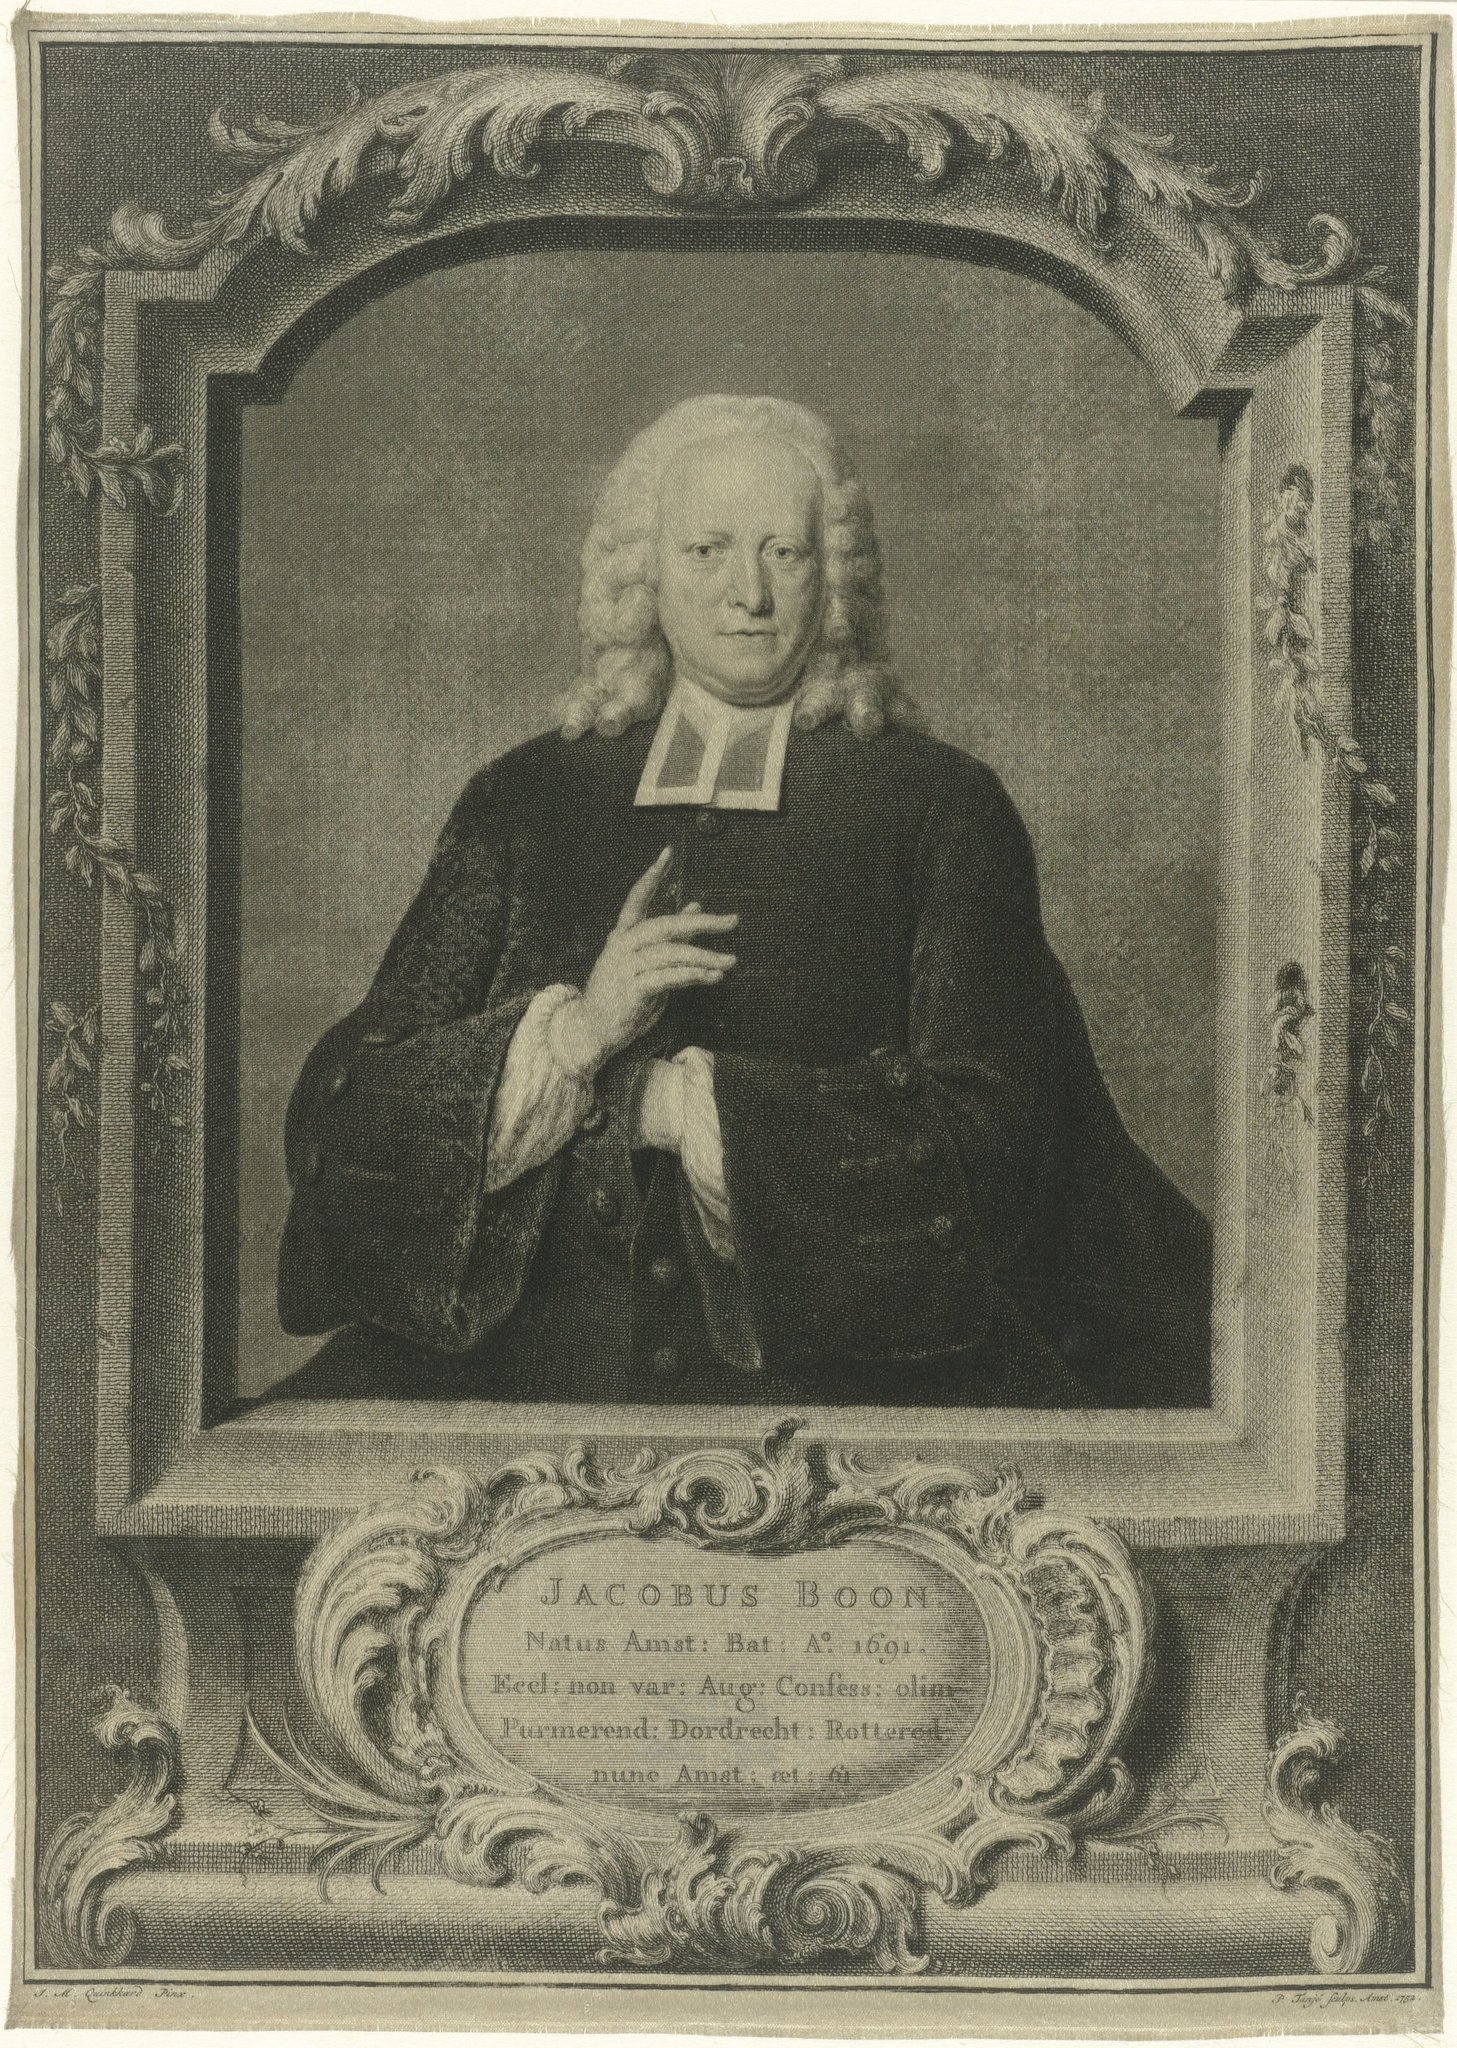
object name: print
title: Portret van Jacobus Boon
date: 1752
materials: textile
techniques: engraving, etching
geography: amsterdam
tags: amsterdam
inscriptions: collector's mark: Lugt 2228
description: Portret van Jacobus Boon, predikant te Amsterdam, op 61-jarige leeftijd.